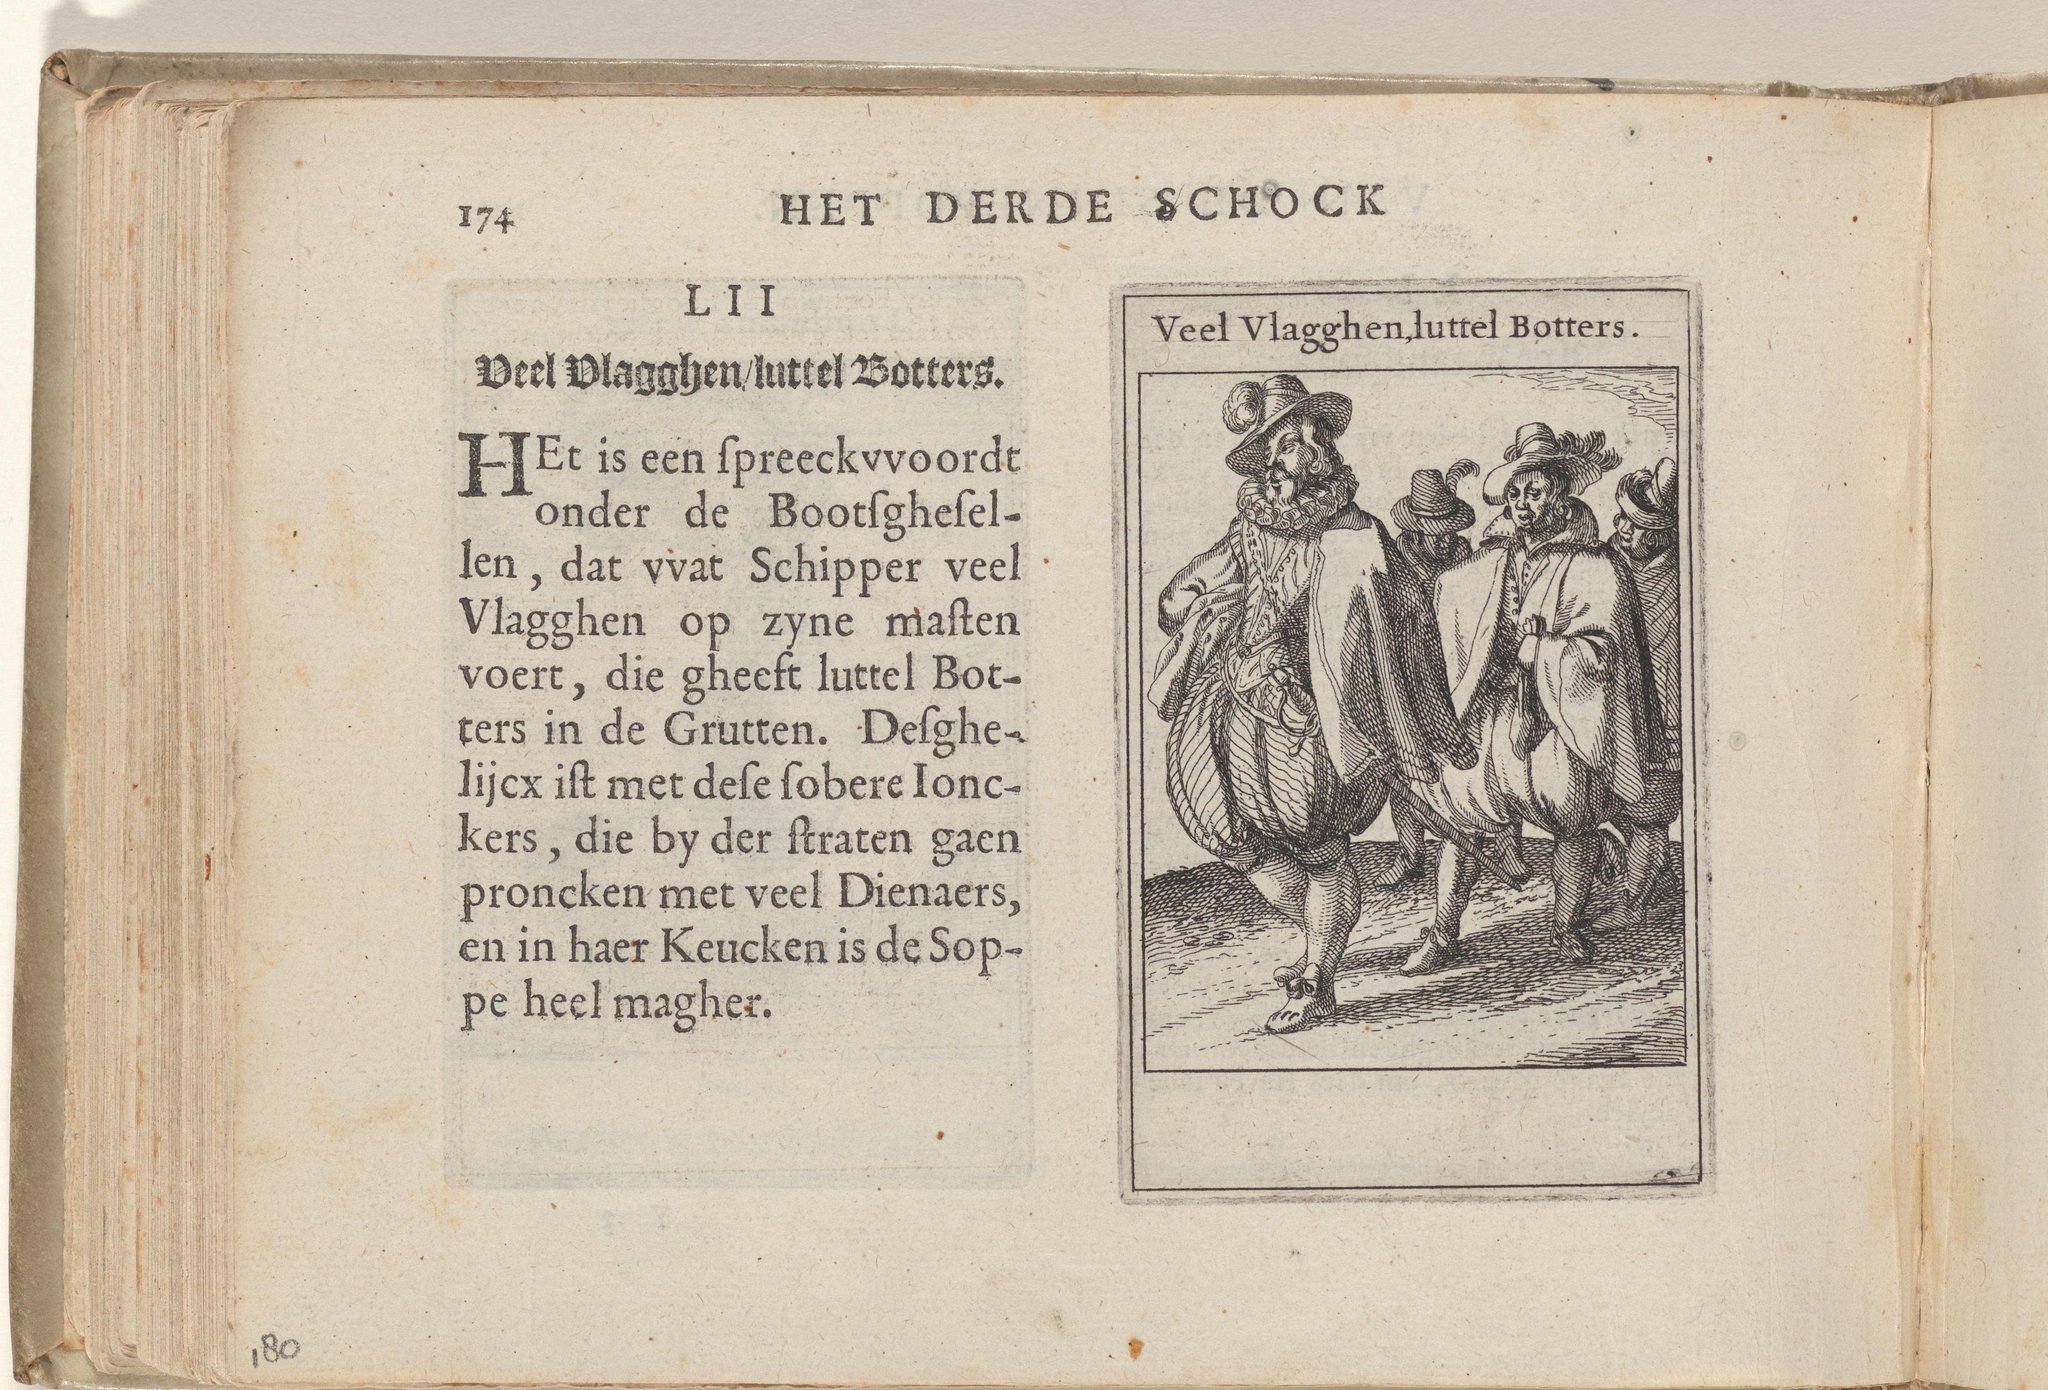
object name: album leaf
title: LII Veel Vlagghen, luttel Botters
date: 1614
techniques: engraving, printing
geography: the hague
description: LII Veel Vlagghen, luttel Botters. Derde schok. Onderdeel van 'Sinnepoppen', R. Visscher, 1614.